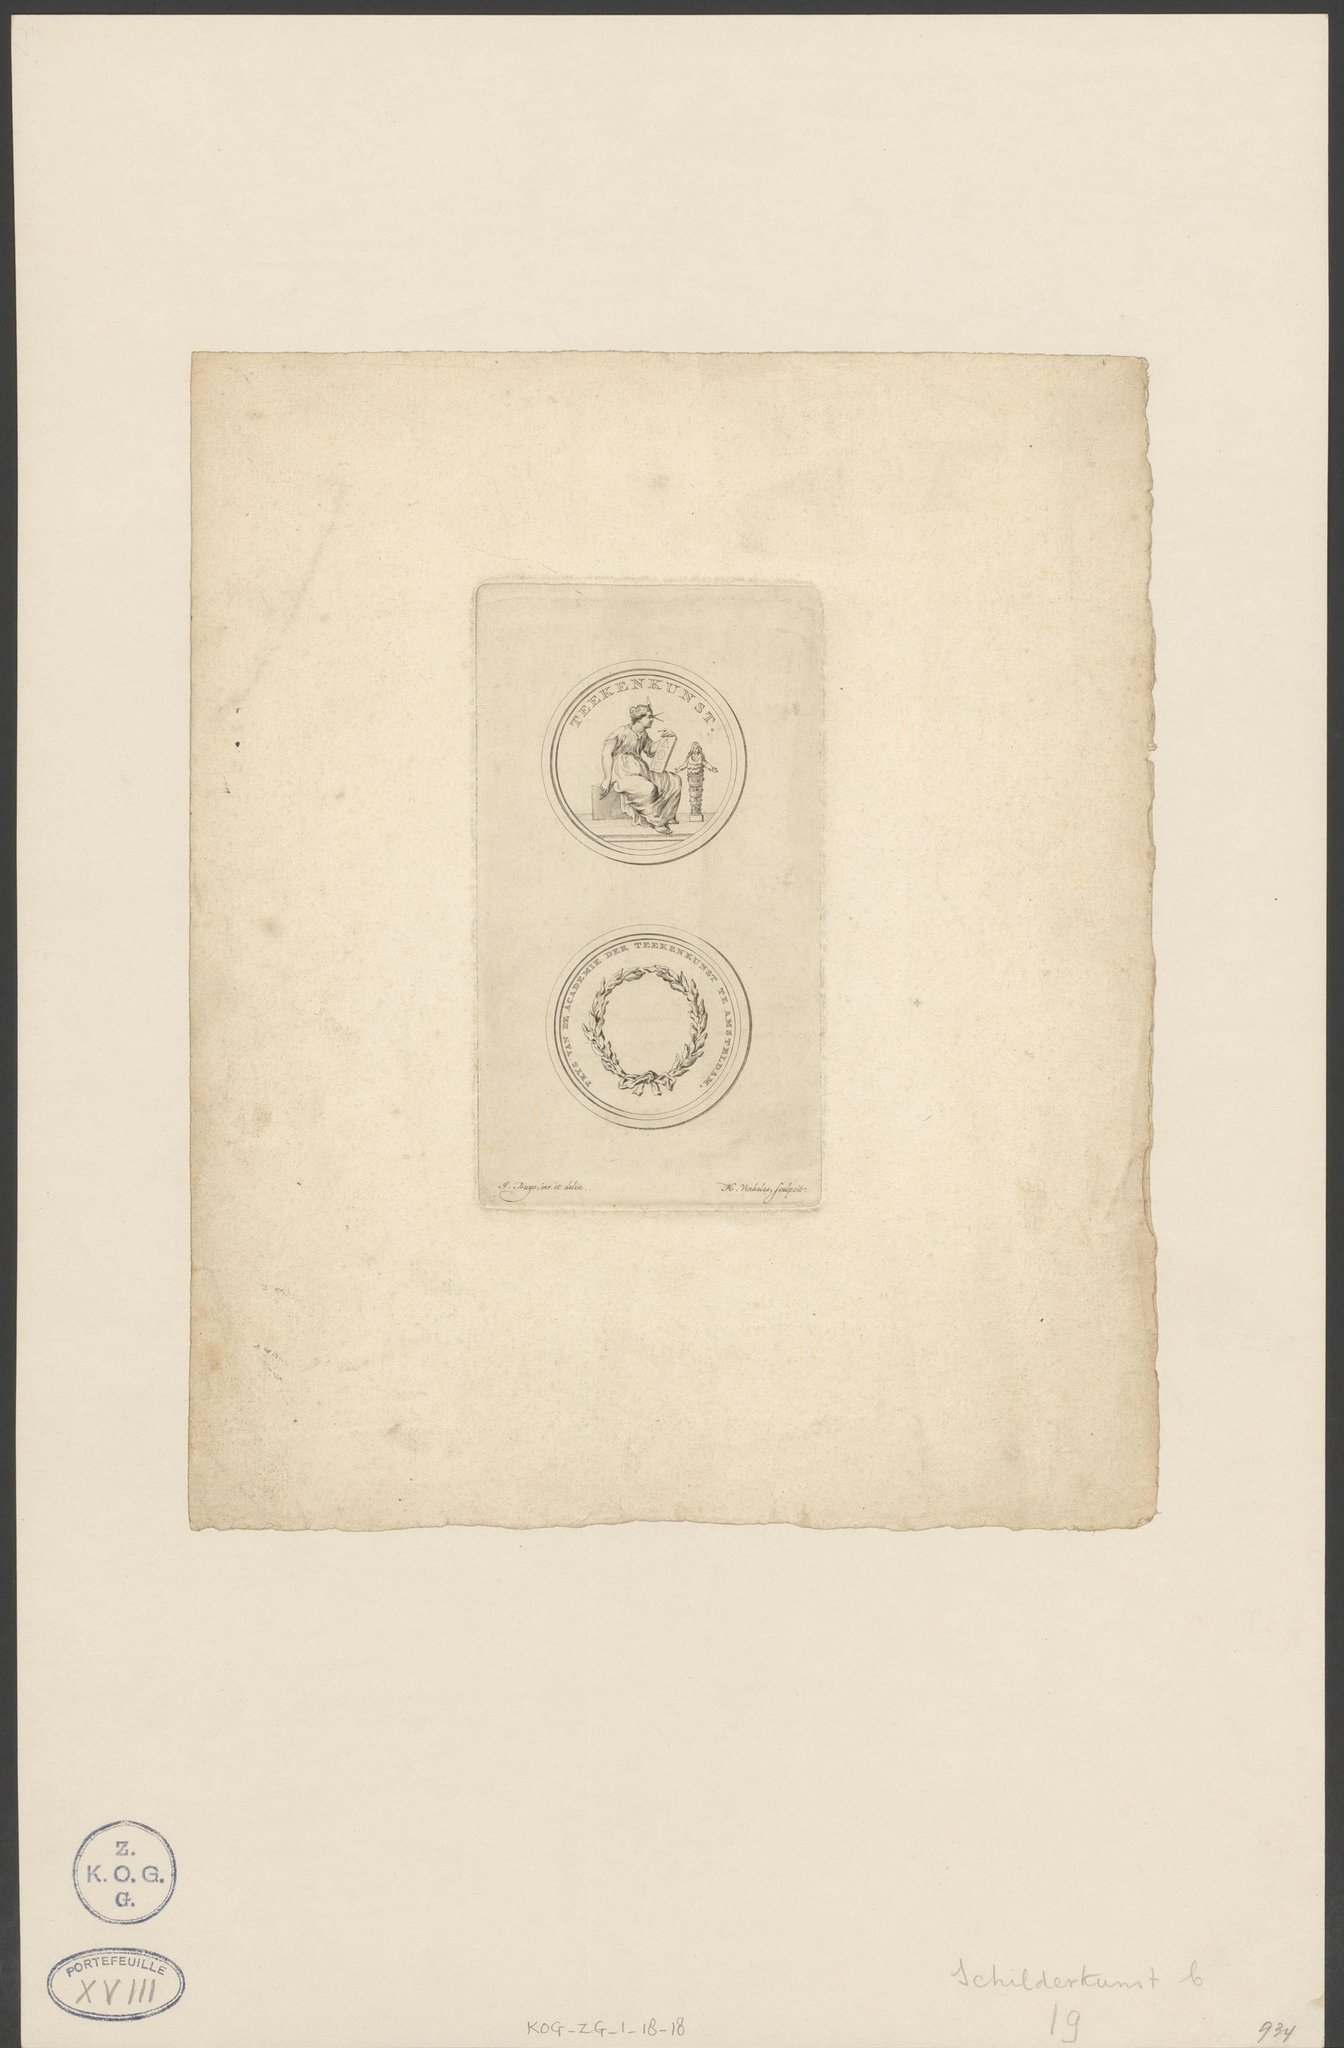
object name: print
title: Voor- en achterzijde van medaille van de academie der tekenkunst te Amsterdam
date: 1765-1800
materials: paper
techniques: engraving, etching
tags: honouring the artist with laurel wreath, memorial medal, compass, symbolic representations, allegories and emblems ~ drawing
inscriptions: collector's mark: Lugt 1641, stamp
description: Tekenkunst, afgebeeld als vrouw met vlam op hoofd, zit met pen en tekenbord in handen op steen tegenover een beeld, dat zij met passer in haar oog opmeet, binnen omschrift. Keerzijde: opschrift binnen lauwerkrans en omschrift. Onderwerpsrubrieken binnen de Atlas Zeden en Gewoonten: Schoone kunsten, Schilderkunst, Kunstonderwijs.